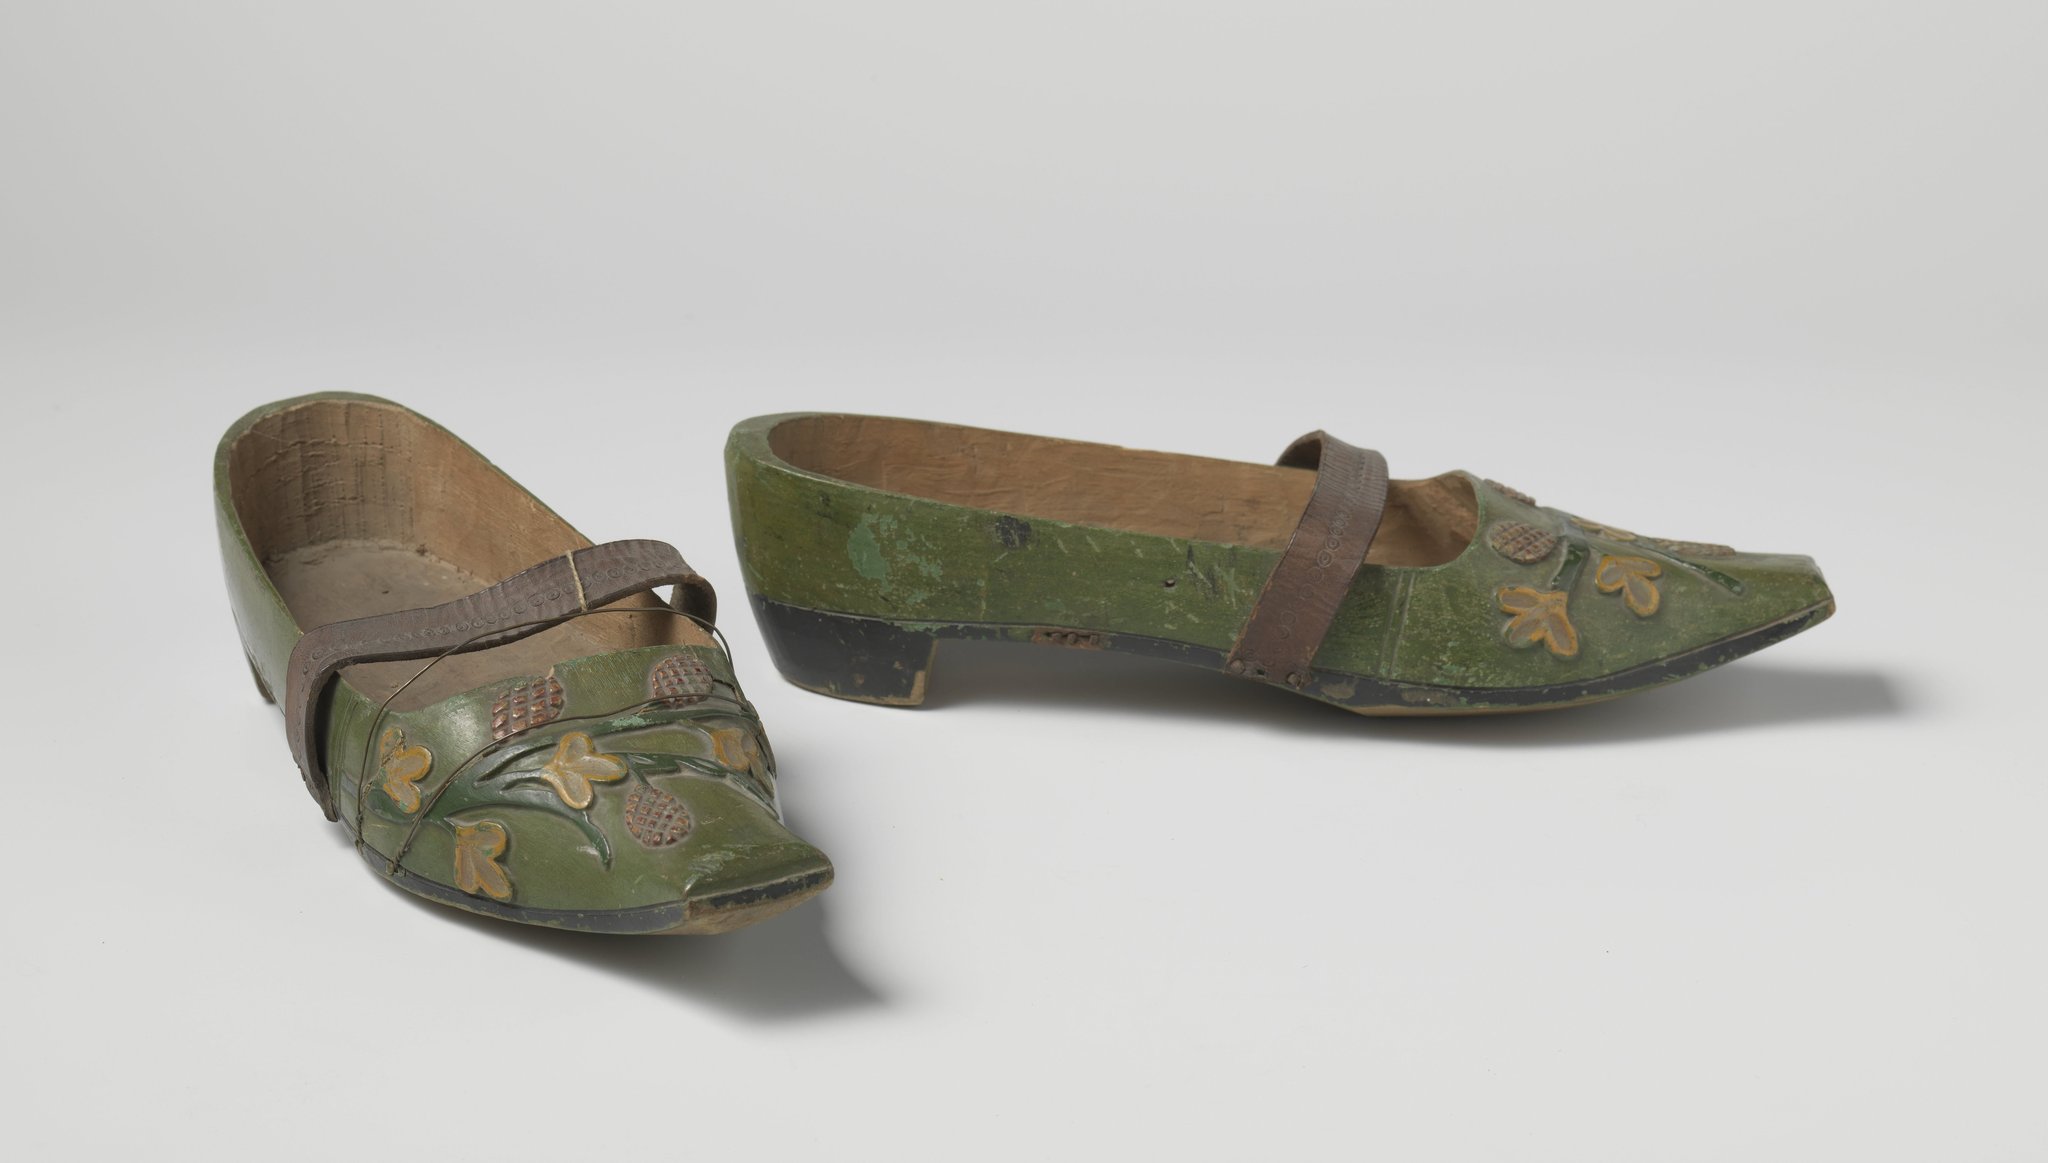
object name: shoe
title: Damesklomp met een dekkende mosgroene verf beschilderd versierd met vrucht en bladranken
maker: Anonymous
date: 1830-1870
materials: iron, leather, paint, wood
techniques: cutting, painting, tanning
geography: northern netherlands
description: Damesklomp met een dekkende mosgroene verf beschilderd. Model: De voorschoen loopt smal toe en eindigt in een vierkante neus. Leren versierde band over de wreef aan beide kanten vastgemaakt met twee spijkertjes. Binnenkant schoen ongeschilderd hout. Houten zool en zwart geschilderde lage hak. Versiering: Op de voorvoet zijn in reliëf ranken met bloemen en bladeren gesneden.